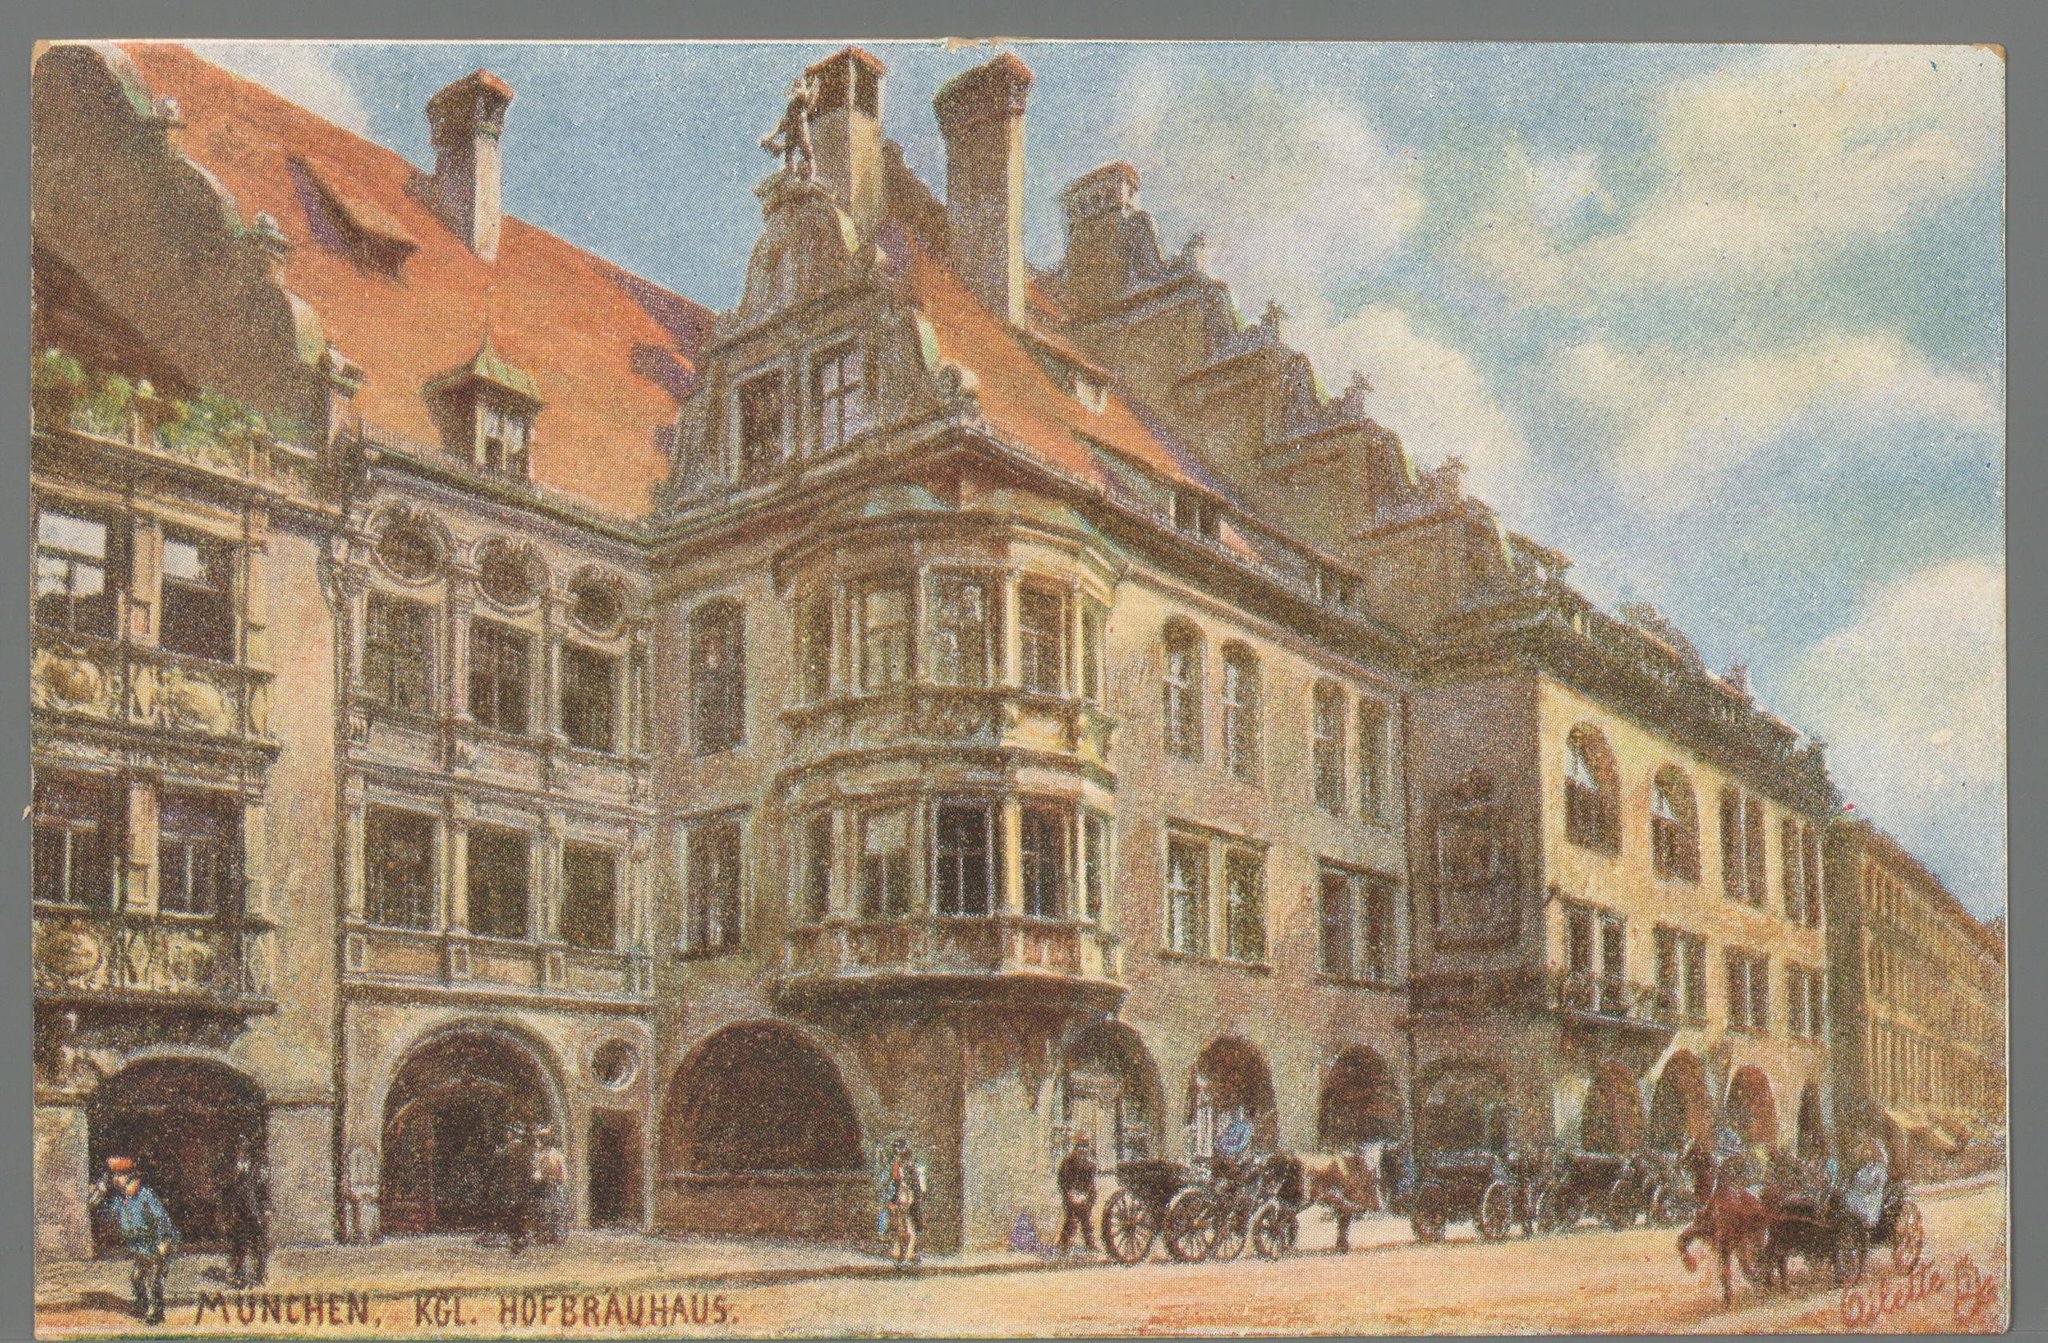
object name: photomechanical print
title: München. Kgl. Hofbräuhaus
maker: Anonymous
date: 1906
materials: cardboard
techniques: writing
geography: berlin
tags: restaurant